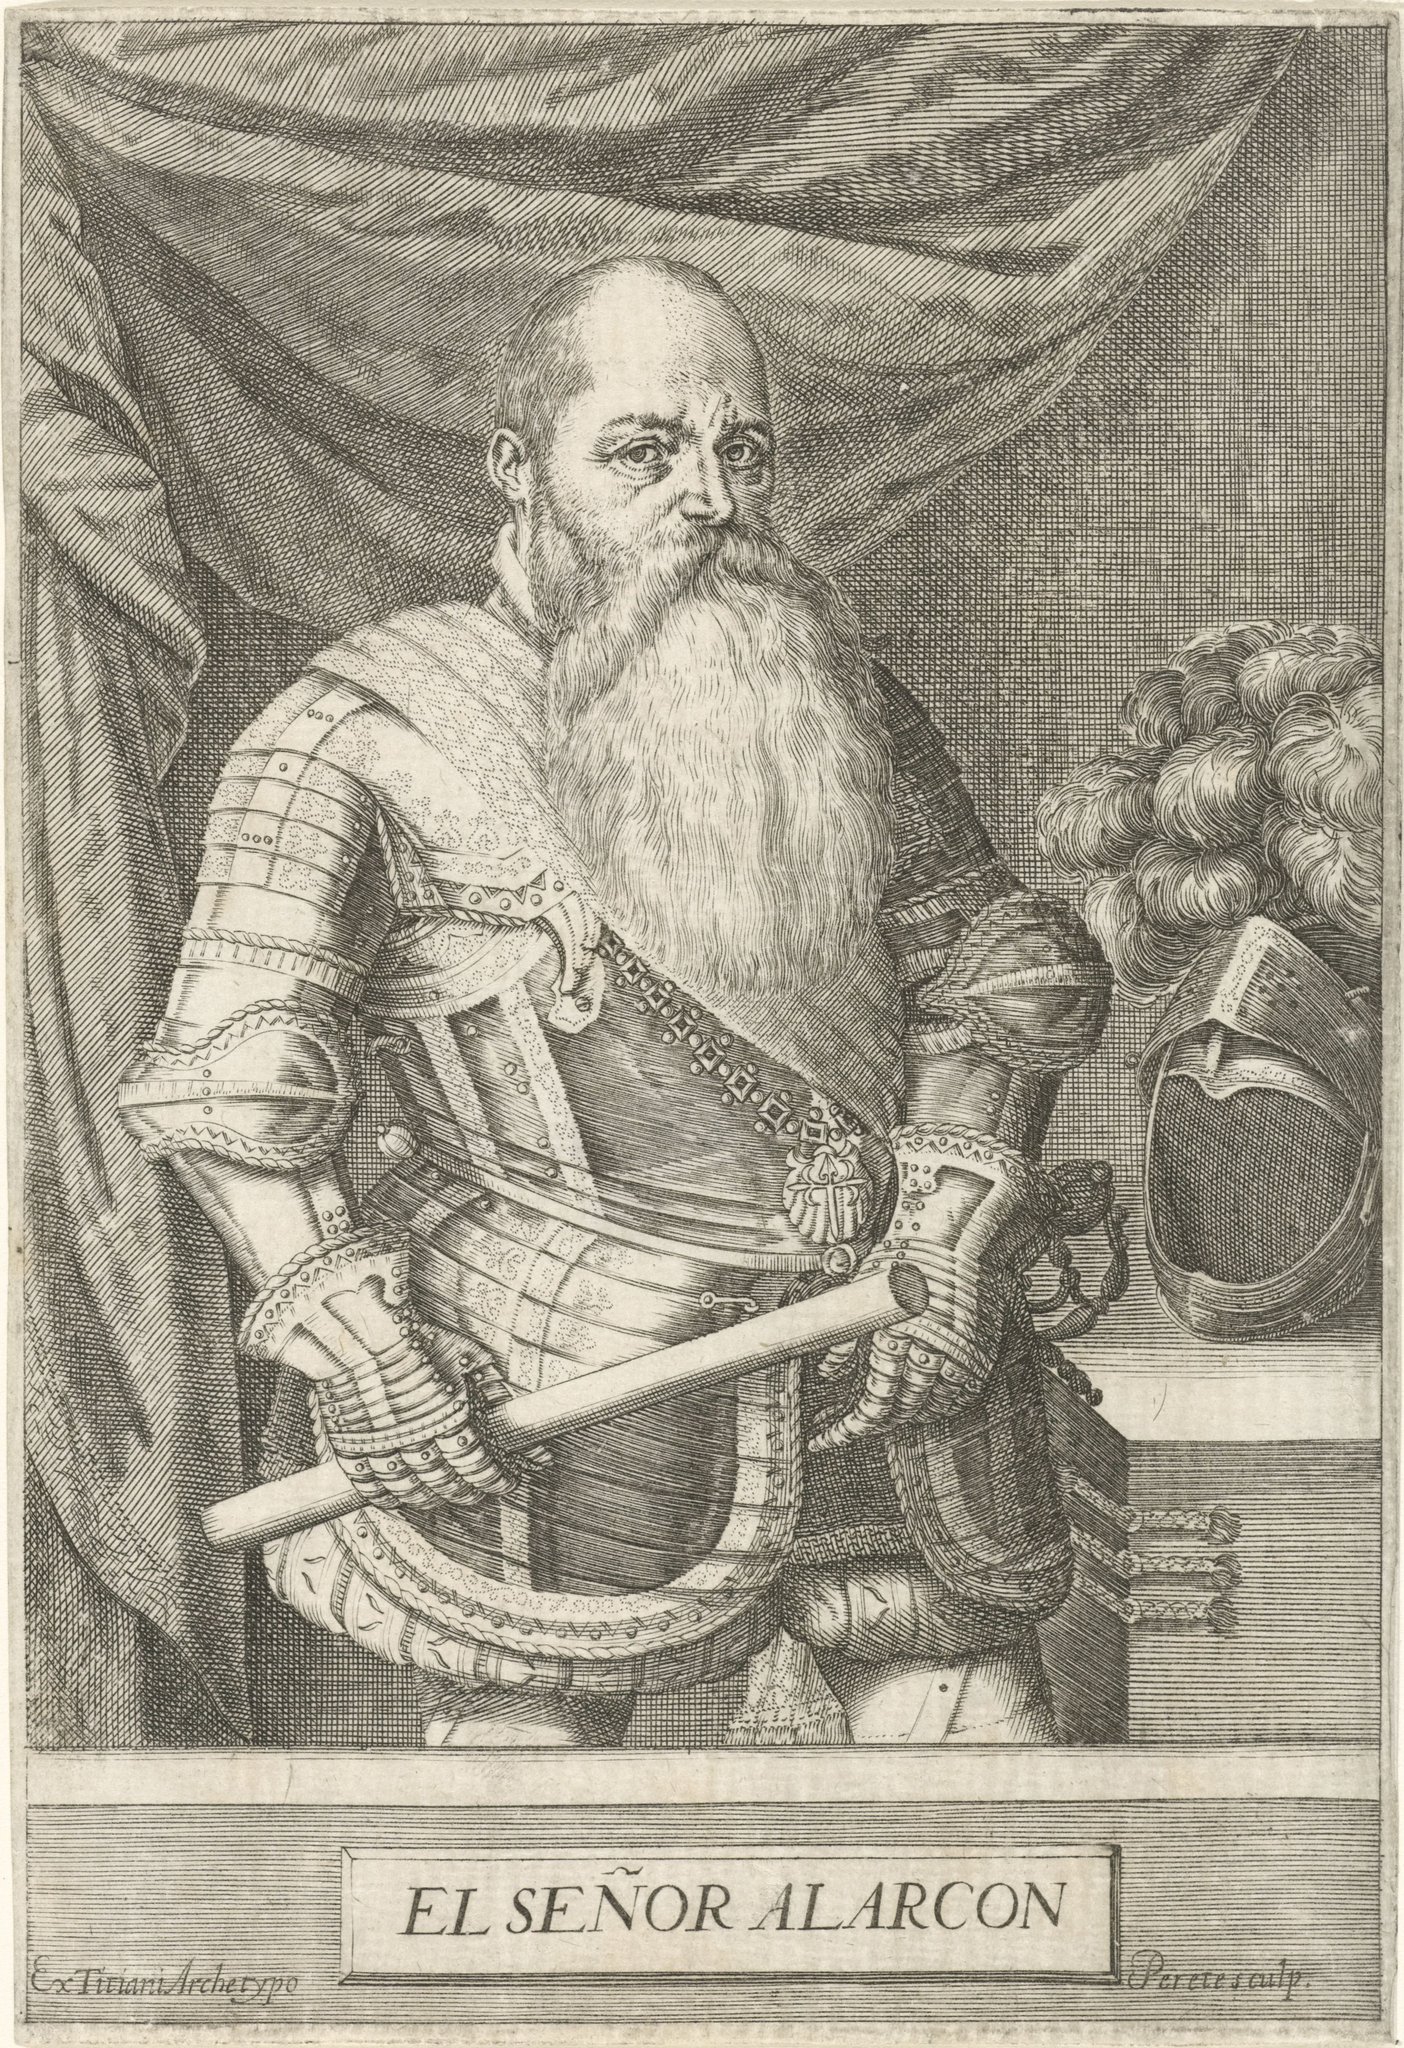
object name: print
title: Portret van Hernando de Alarcón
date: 1581-1625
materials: paper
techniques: engraving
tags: armour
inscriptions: collector's mark: Lugt 2228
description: Portret van de Spaanse ontdekkingsreiziger Hernando de Alarcón.